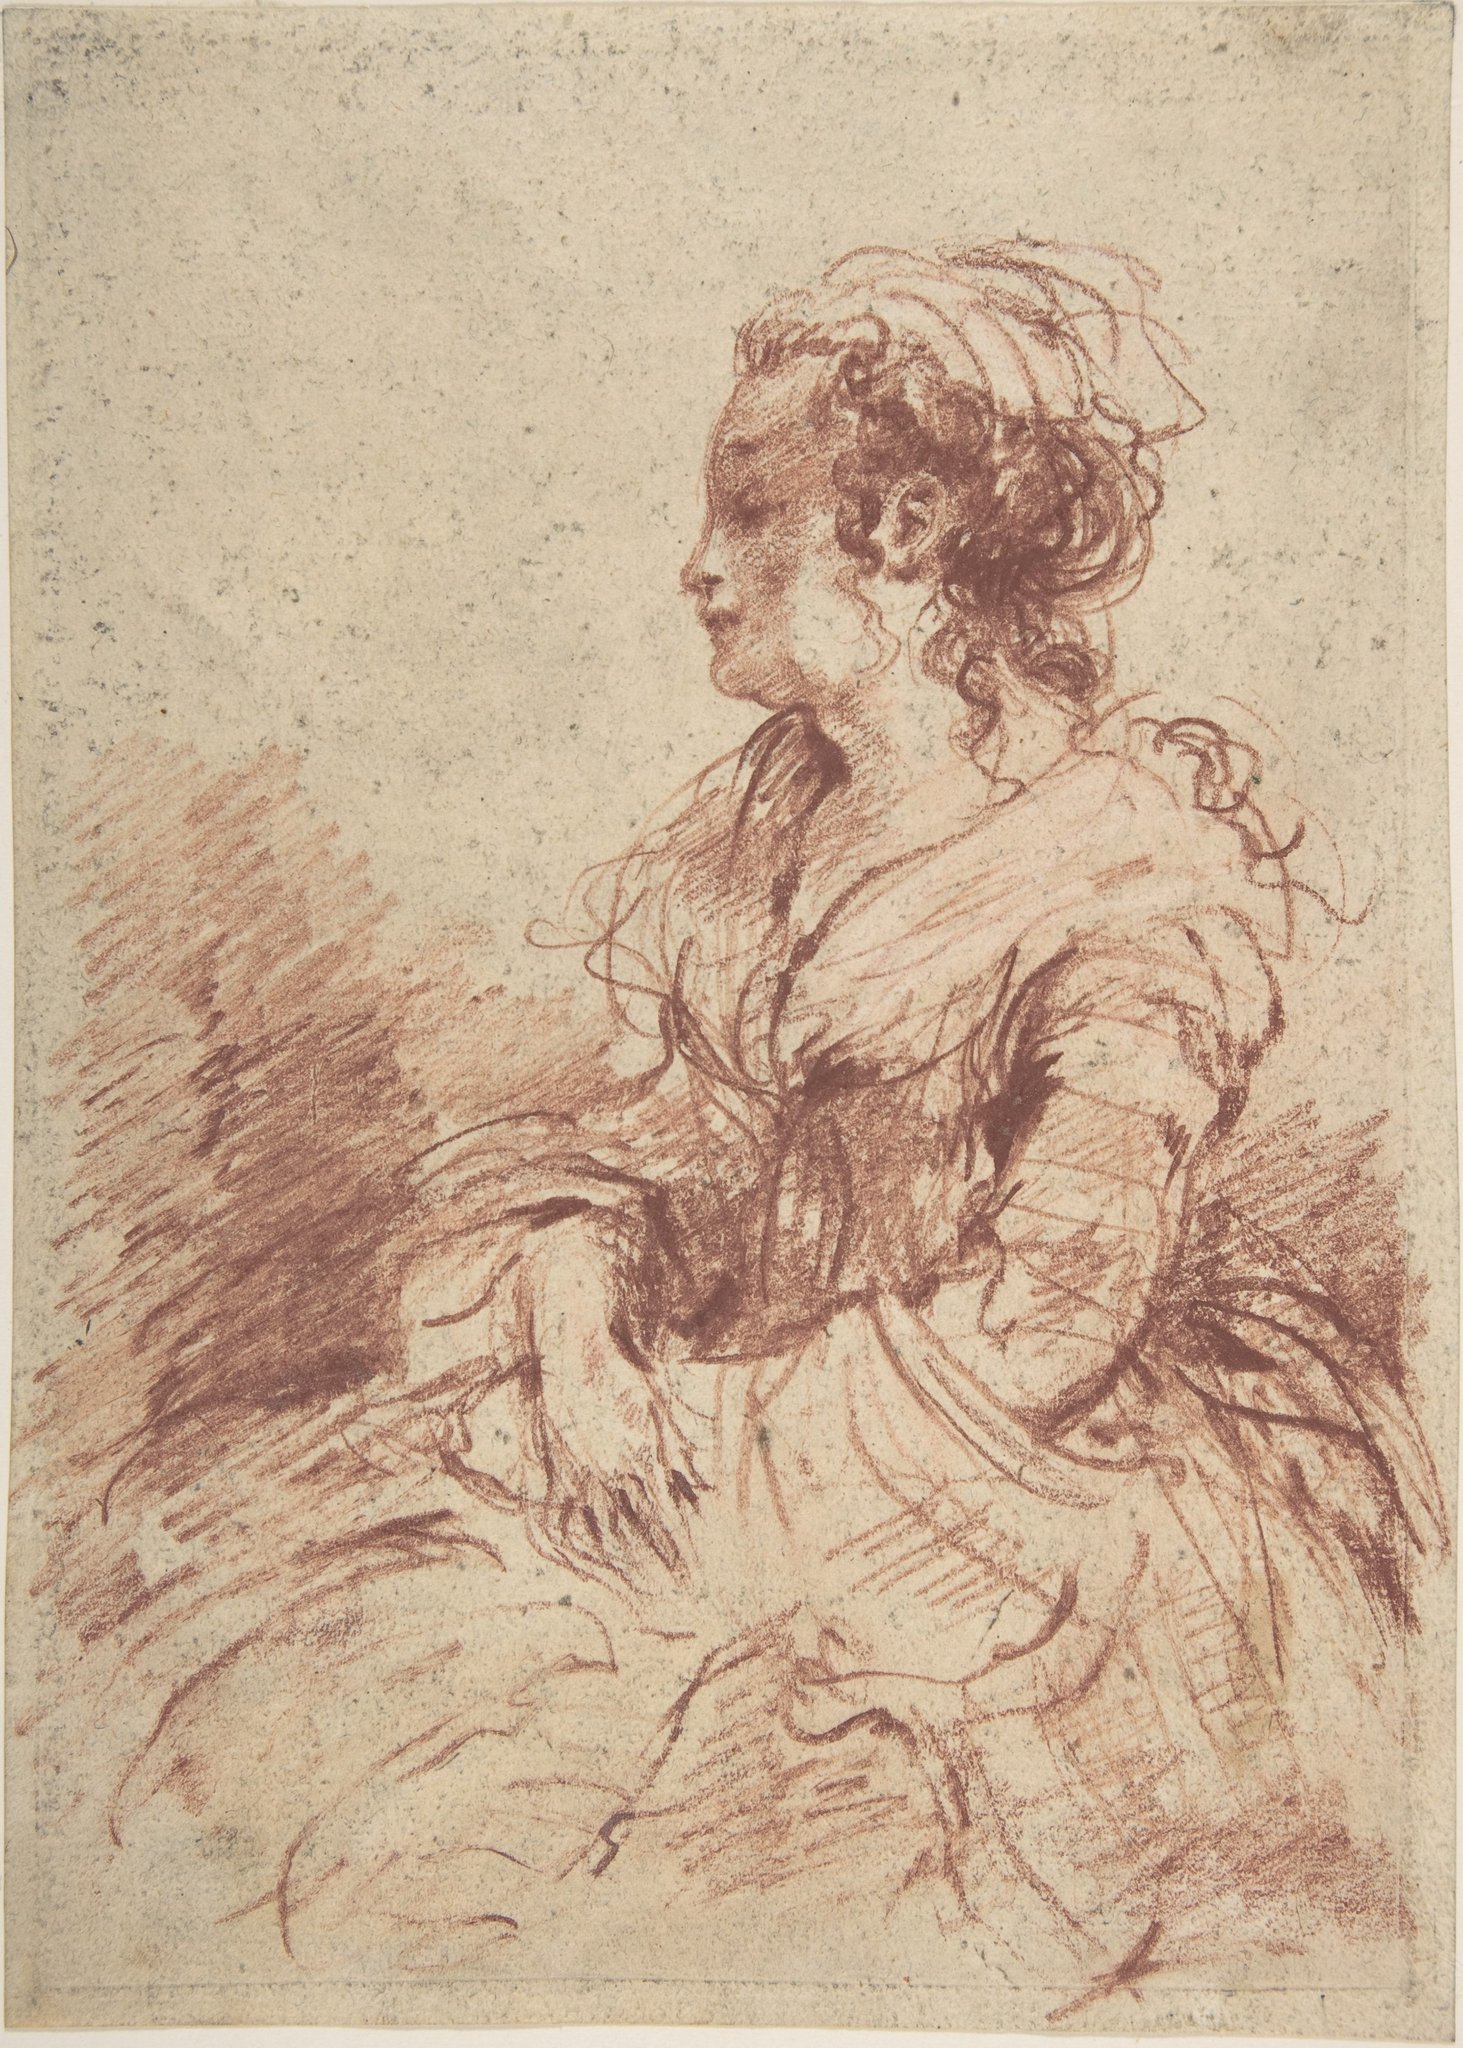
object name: drawing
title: Portrait of a Lady, seated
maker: anonymous, french, 18th century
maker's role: artist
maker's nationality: french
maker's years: 1700-1800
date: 1701-1800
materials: chalk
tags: profiles,women